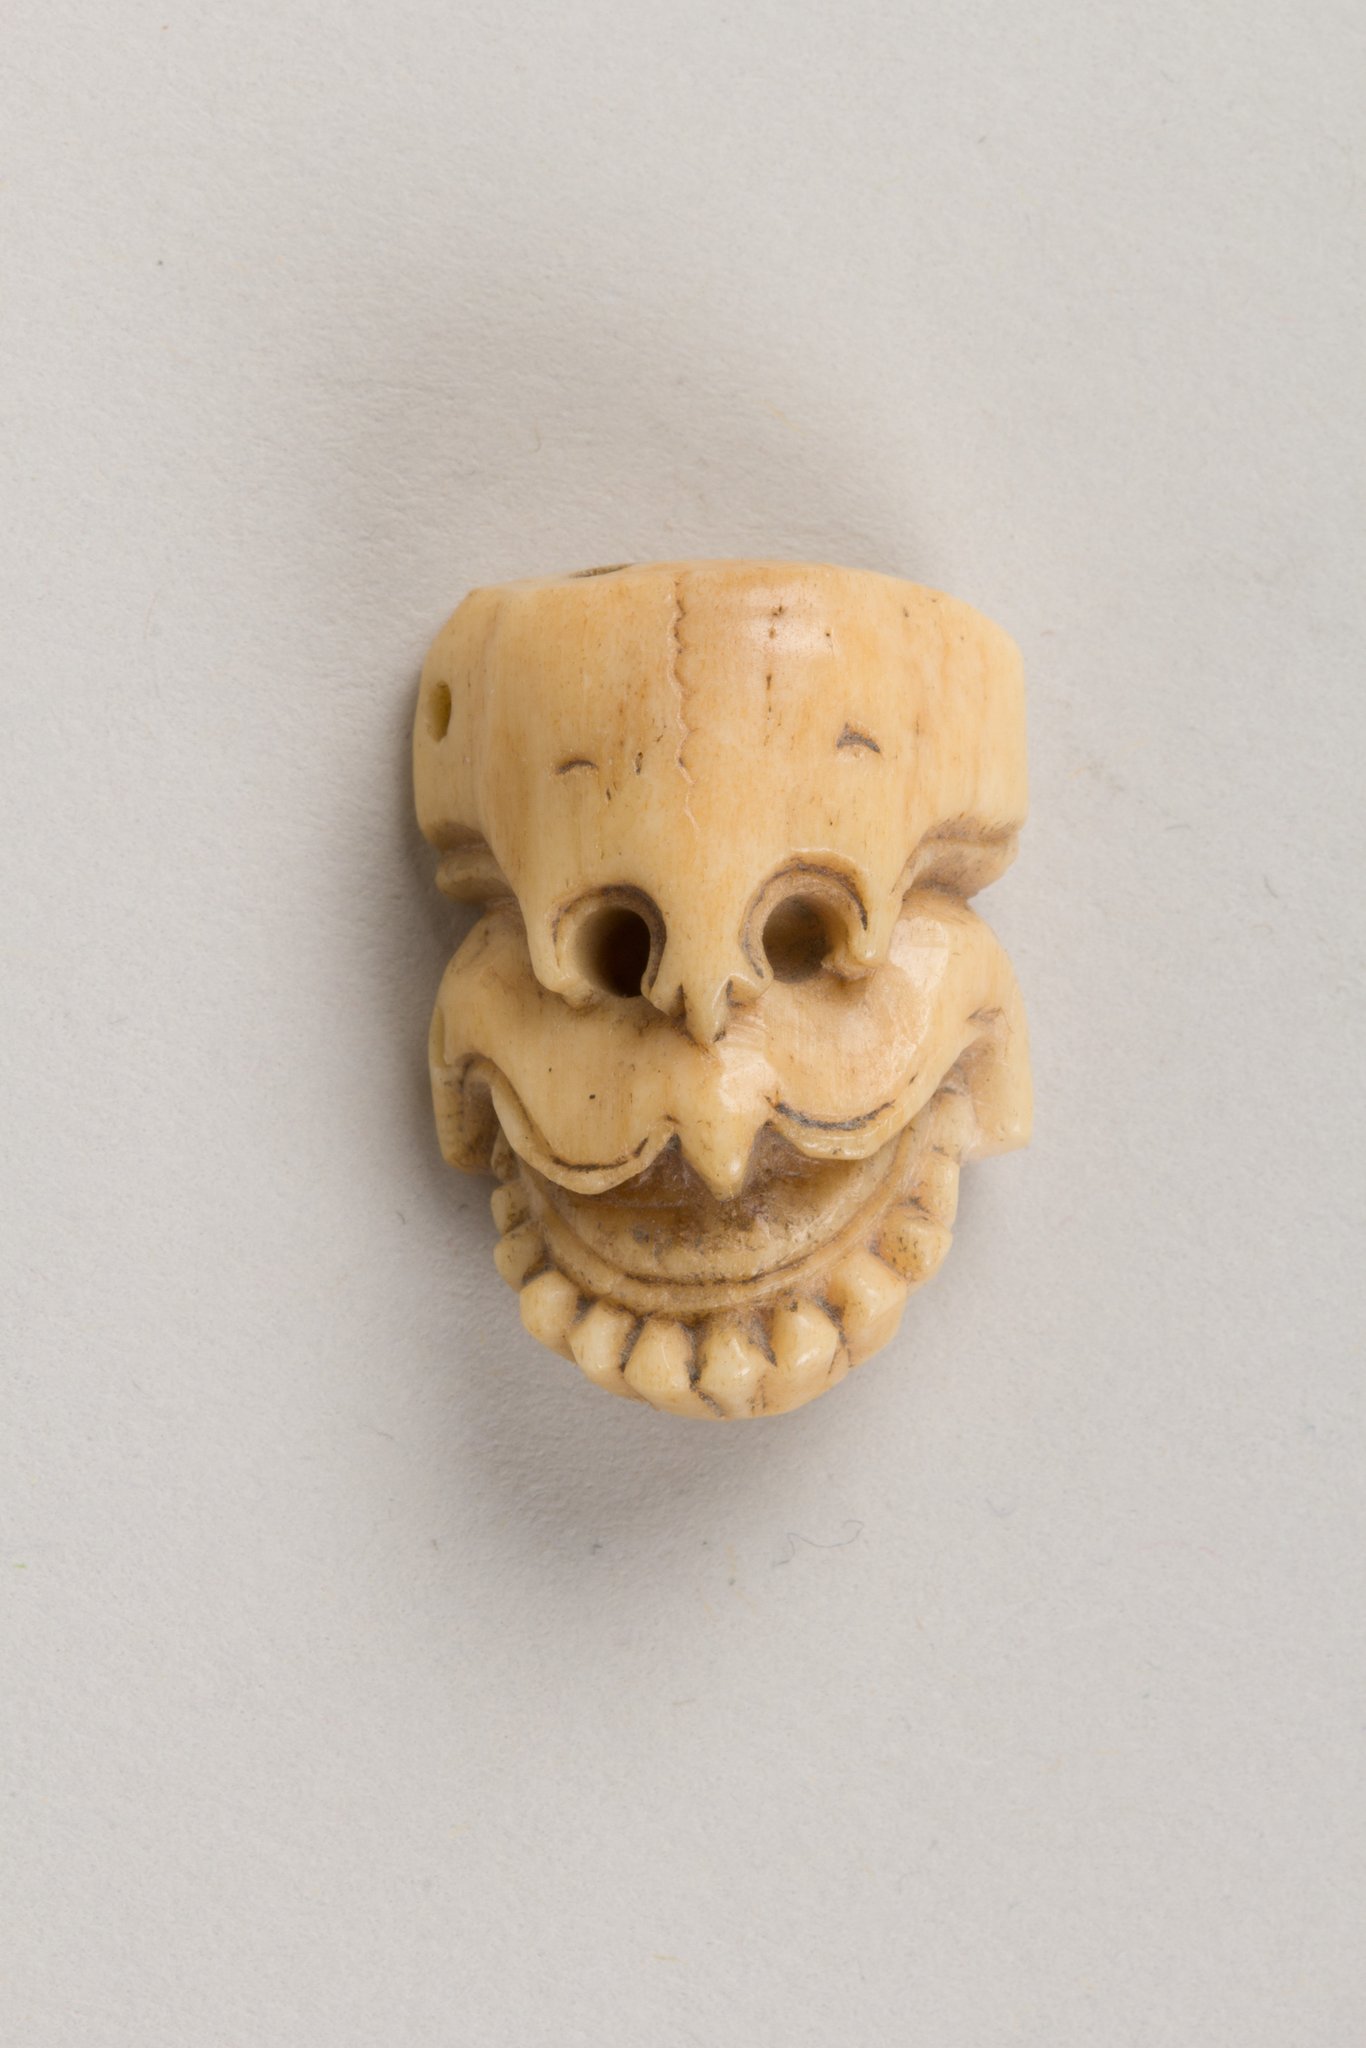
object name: ritual carving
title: Skull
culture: tibetan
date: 1501-1600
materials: bone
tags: skulls